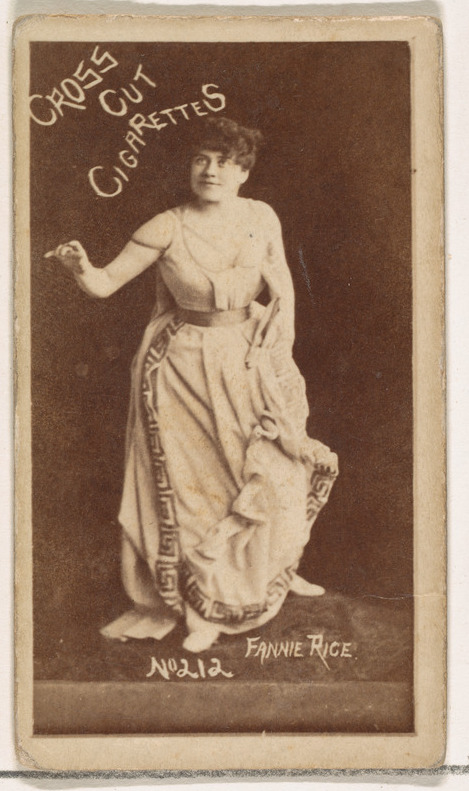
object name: print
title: Card Number 212, Fanny Rice, from the Actors and Actresses series (N145-1) issued by Duke Sons & Co. to promote Cross Cut Cigarettes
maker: w. duke, sons & co.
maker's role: publisher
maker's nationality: american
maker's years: 1870-1920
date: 1880-1889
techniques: albumen silver print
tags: portraits,women,actresses